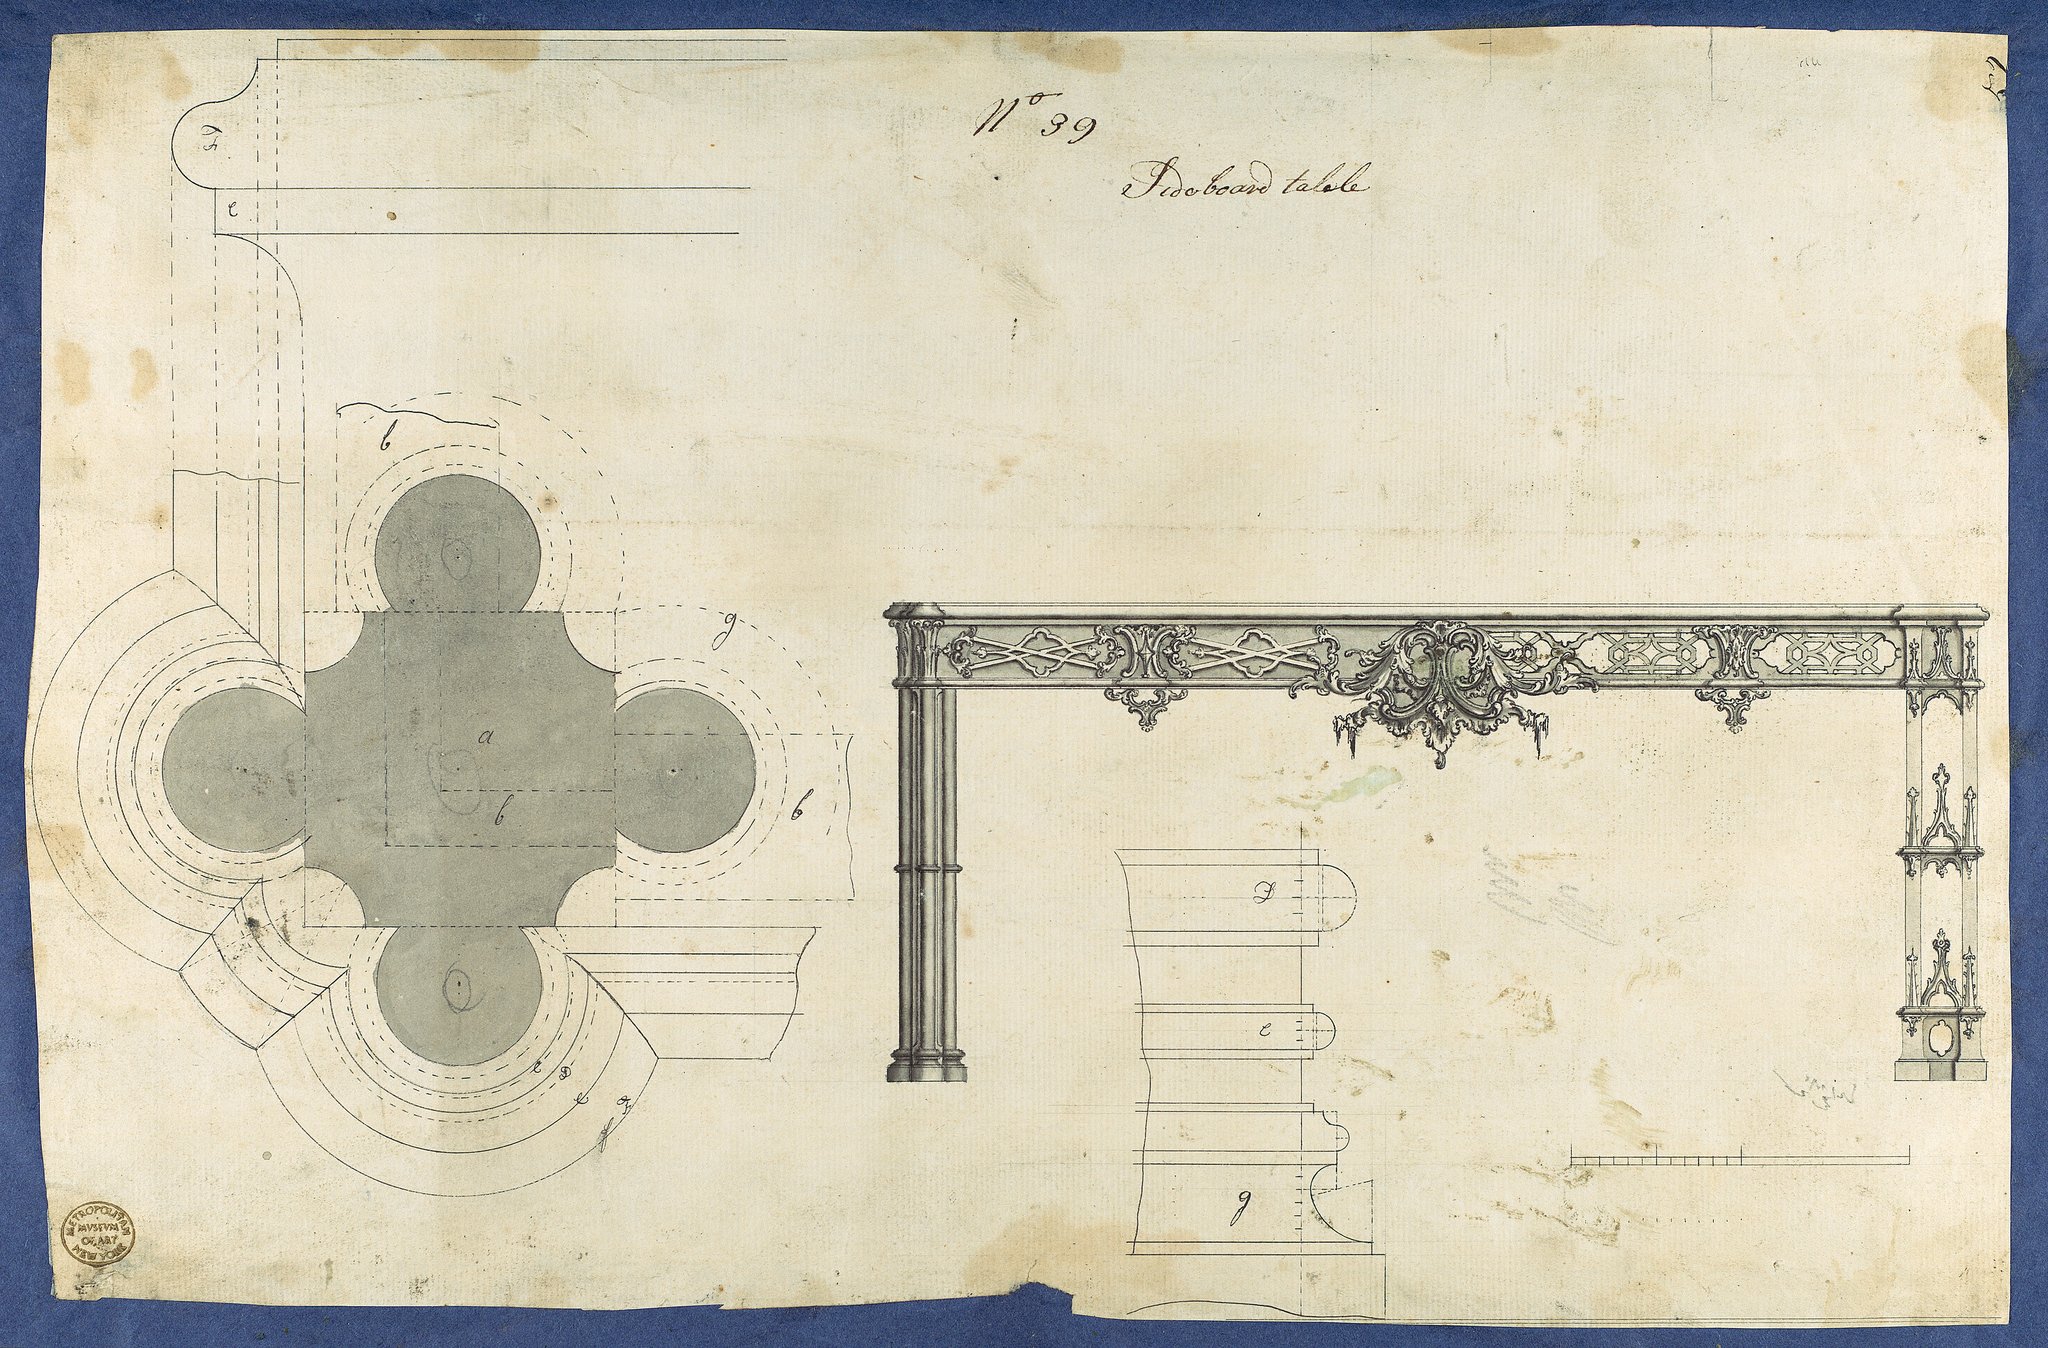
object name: drawing ornament architecture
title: Sideboard Table, from Chippendale Drawings, Vol. II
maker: thomas chippendale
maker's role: artist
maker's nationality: british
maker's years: 1718-1779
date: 1753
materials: ink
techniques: wash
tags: tables